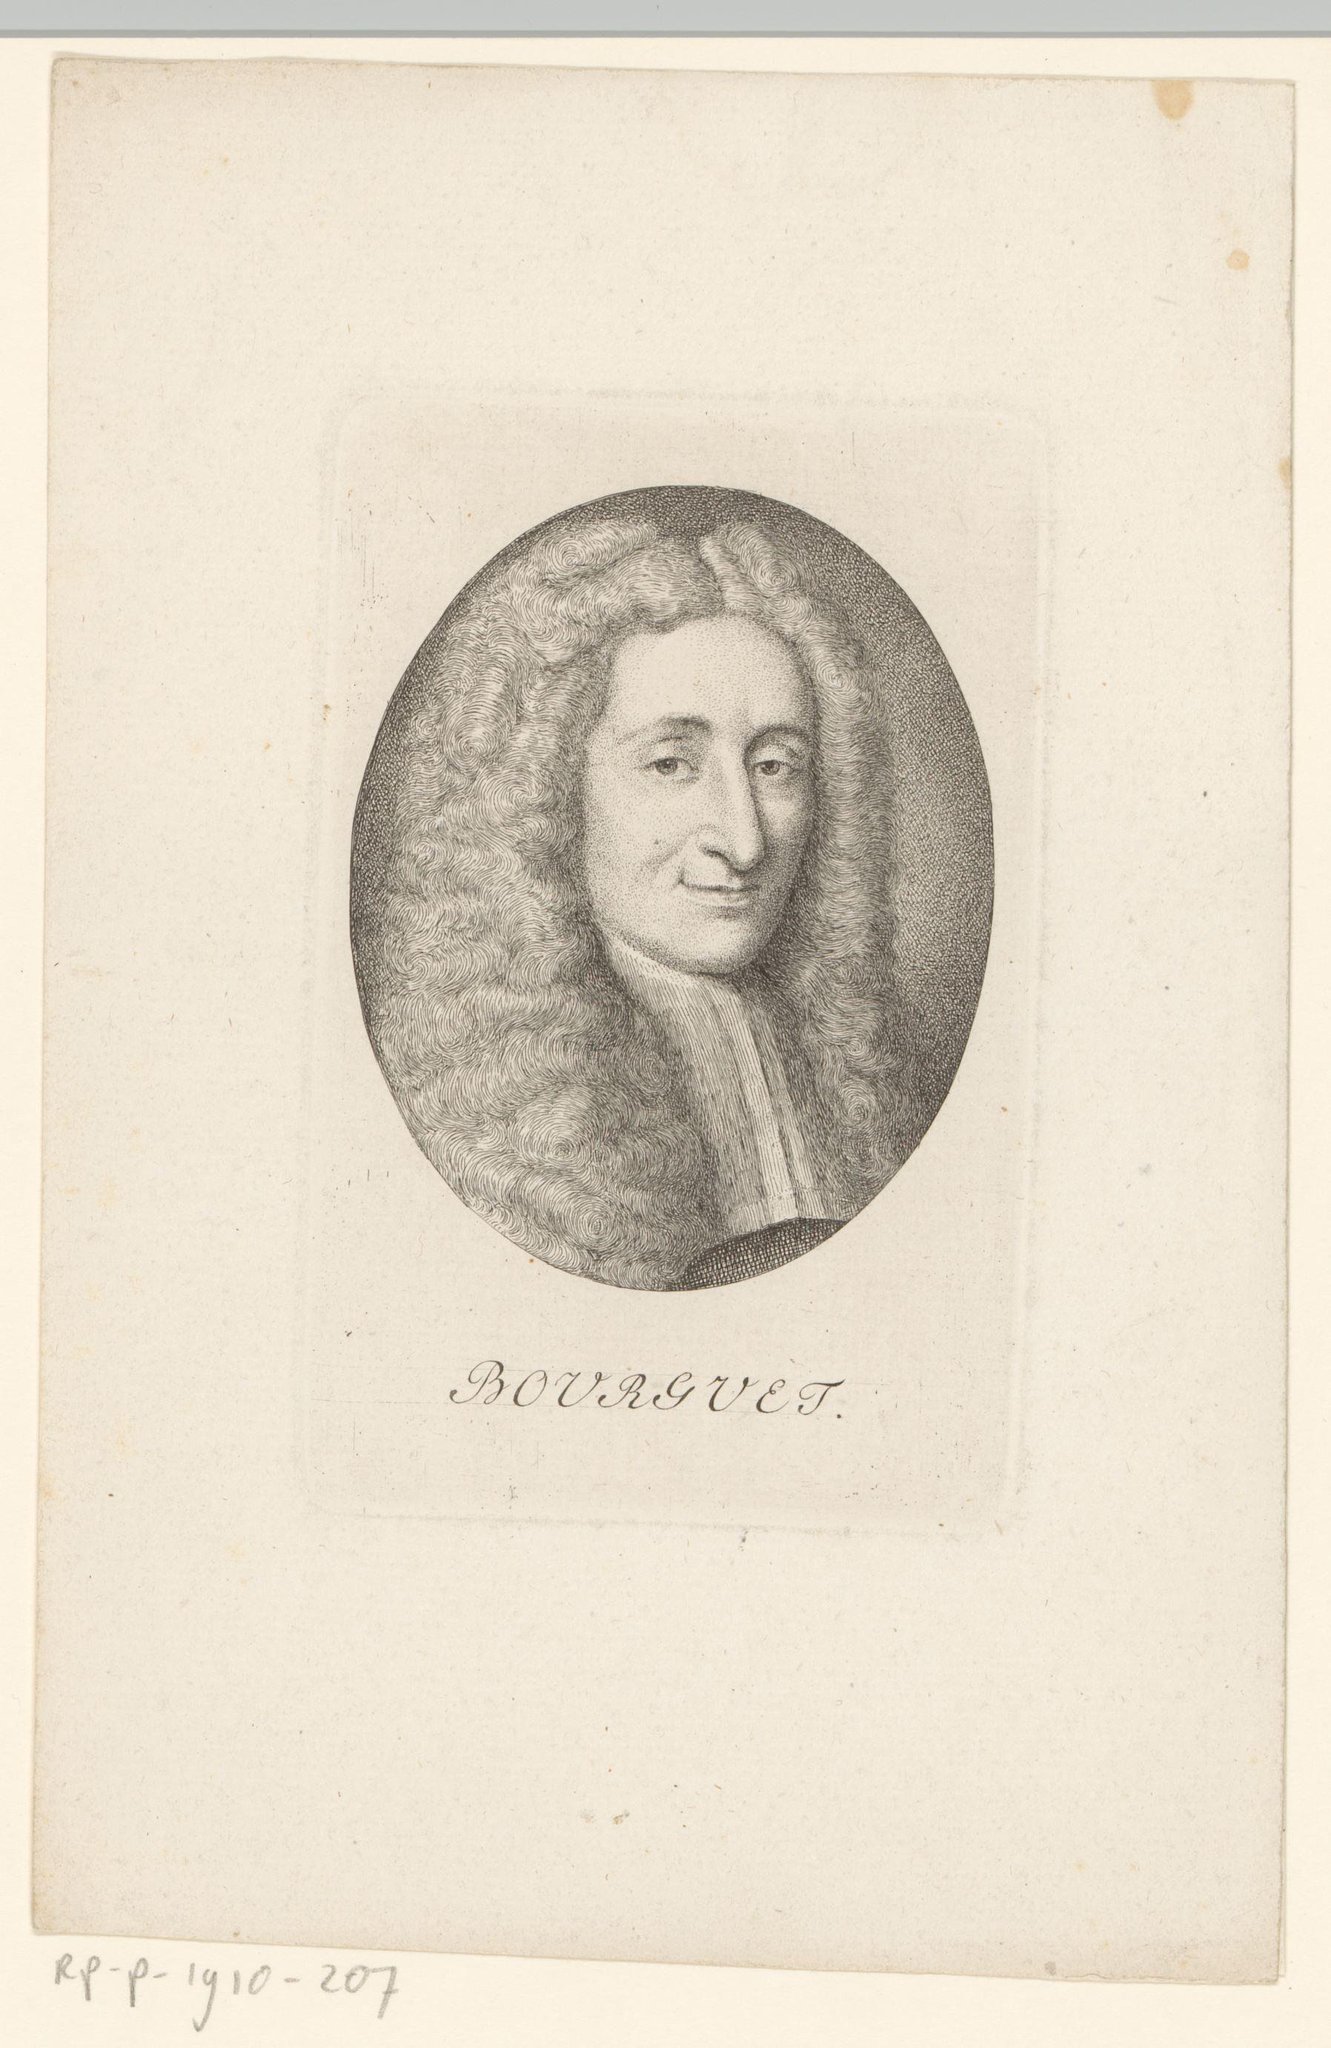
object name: print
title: Portret van Bourquet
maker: heinrich pfenninger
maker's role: print maker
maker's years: 1749-1815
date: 1759-1815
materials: paper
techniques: etching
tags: historical persons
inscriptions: collector's mark: Lugt 2228